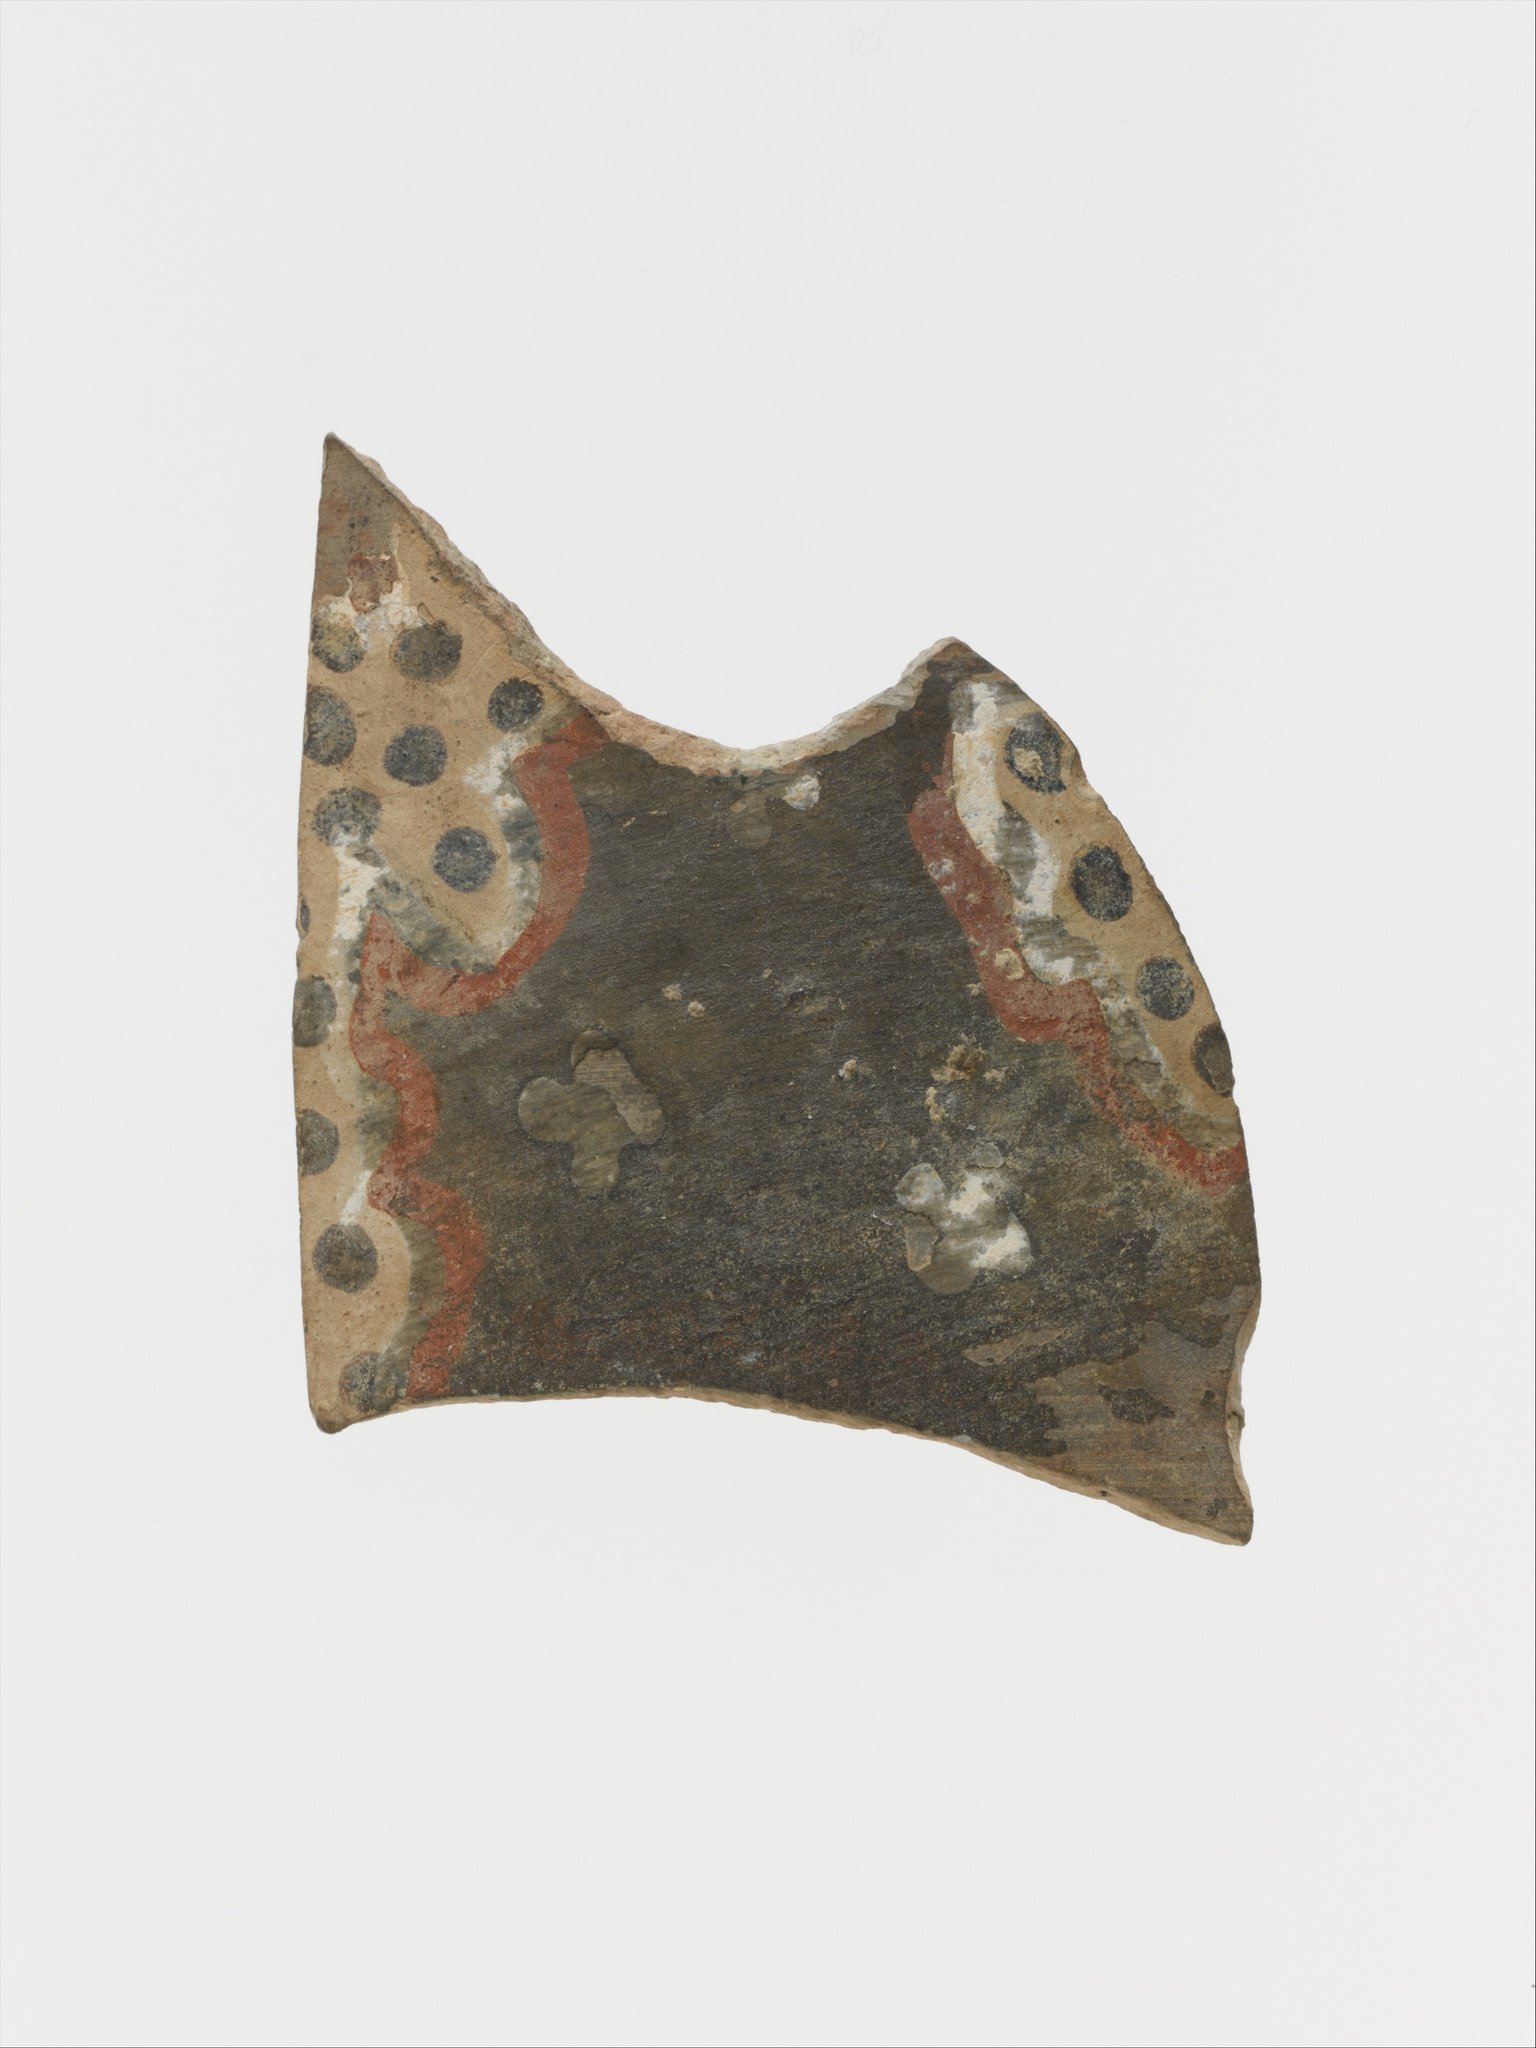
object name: vase fragment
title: Terracotta vessel fragment with polychrome motifs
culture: minoan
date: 1800-1700 BCE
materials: terracotta